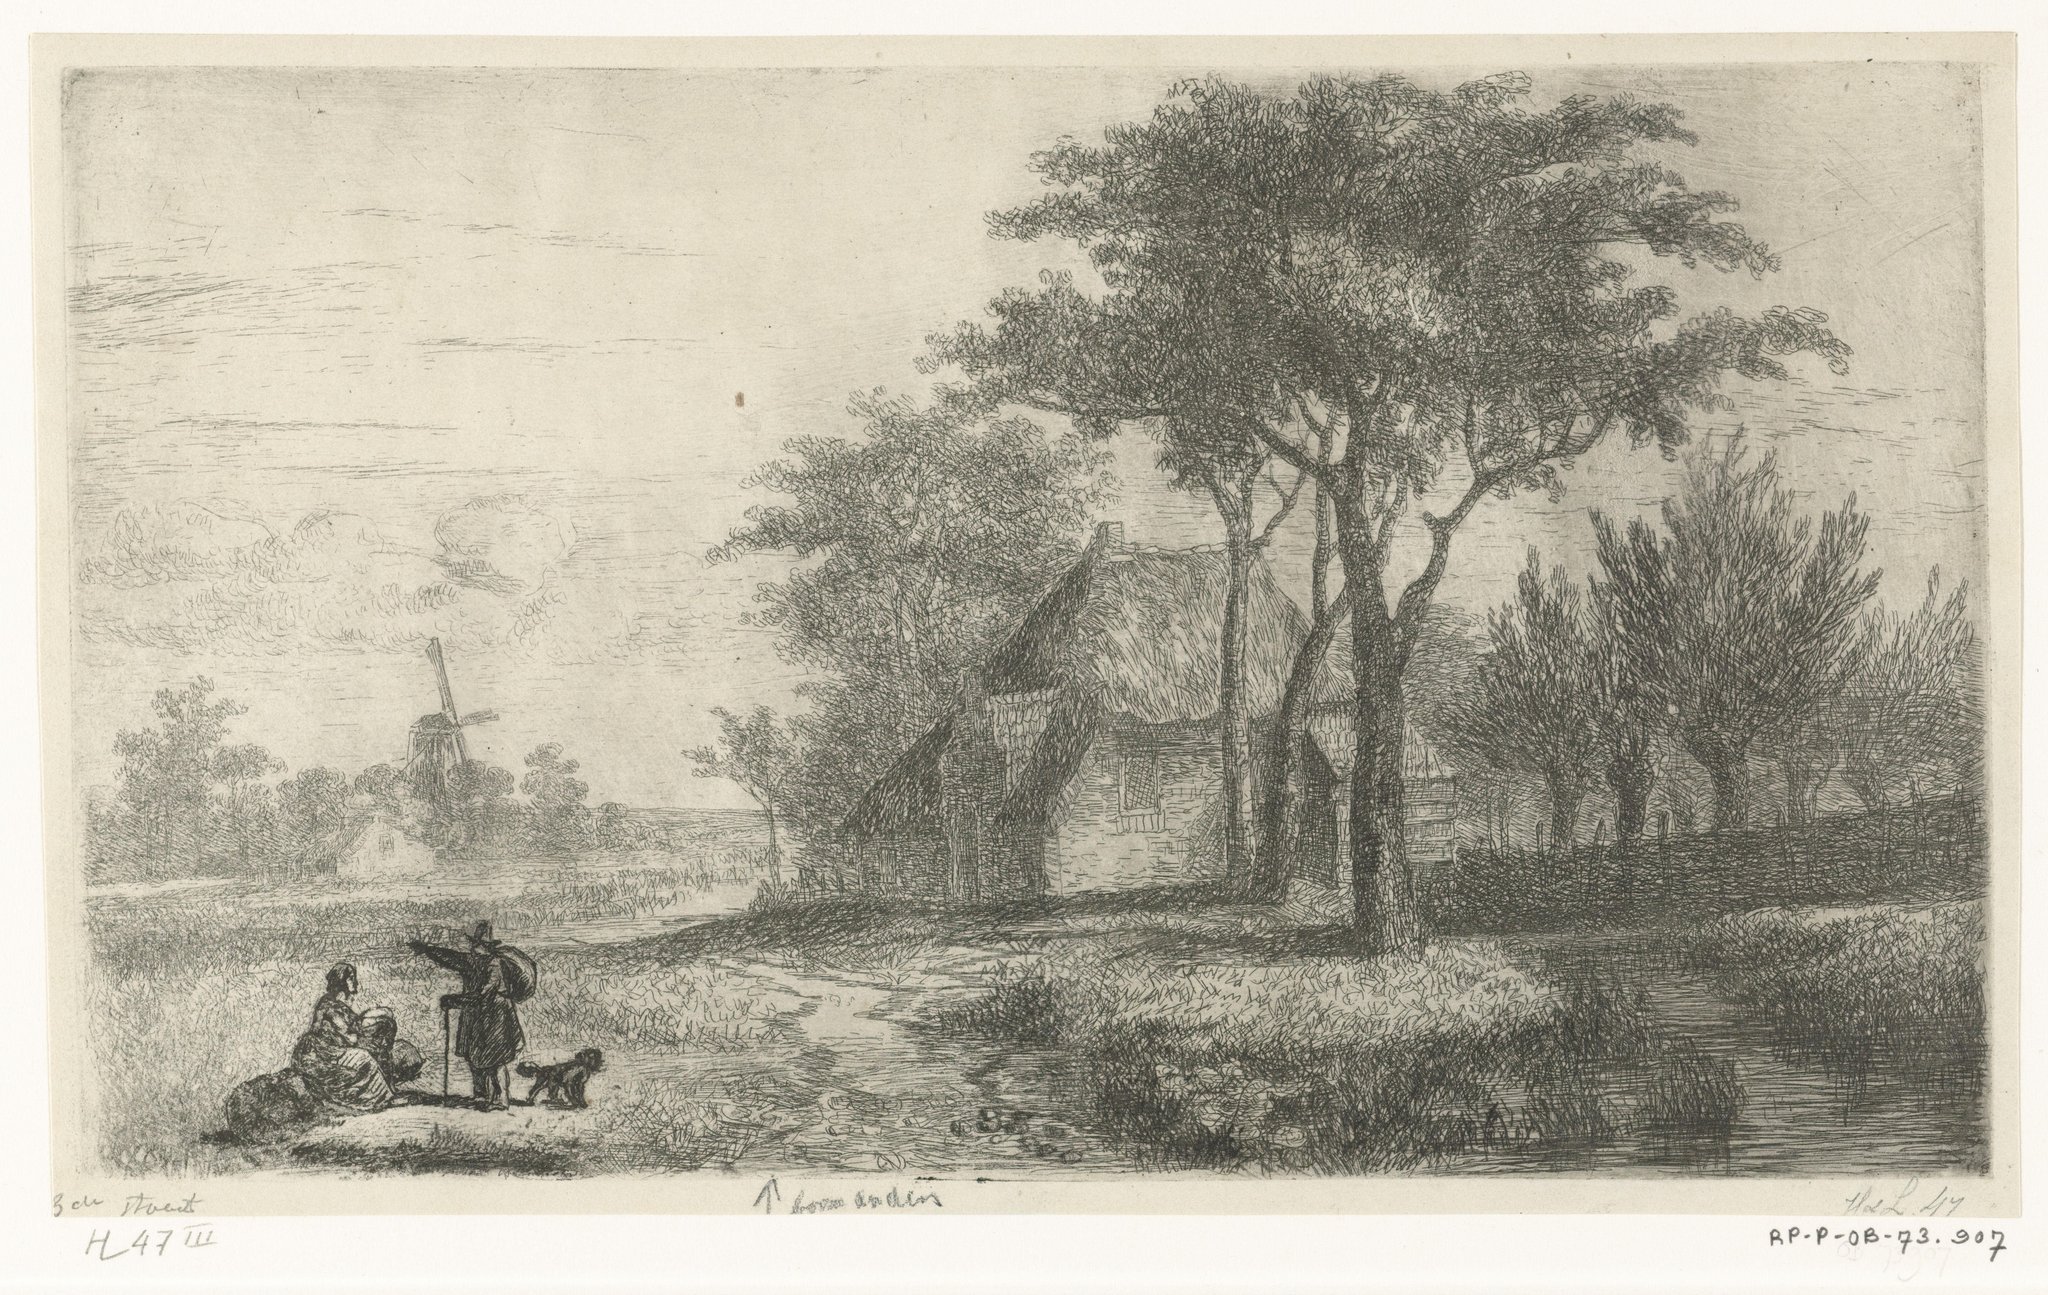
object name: print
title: Landschap met een wandelaar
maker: hermanus jan hendrik van rijkelijkhuysen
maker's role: painter, print maker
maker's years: 1813-1883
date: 1857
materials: paper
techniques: drypoint, etching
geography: utrecht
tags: trees, windmill, 'en route', traveller under way, farm or solitary house in landscape, dog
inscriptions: collector's mark: Lugt 2228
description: Een vlak landschap met op de voorgrond een wandelaar die mogelijk de weg vraagt. Rechts een boerenhoeve aan een stroompje en op de achtergrond een windmolen.